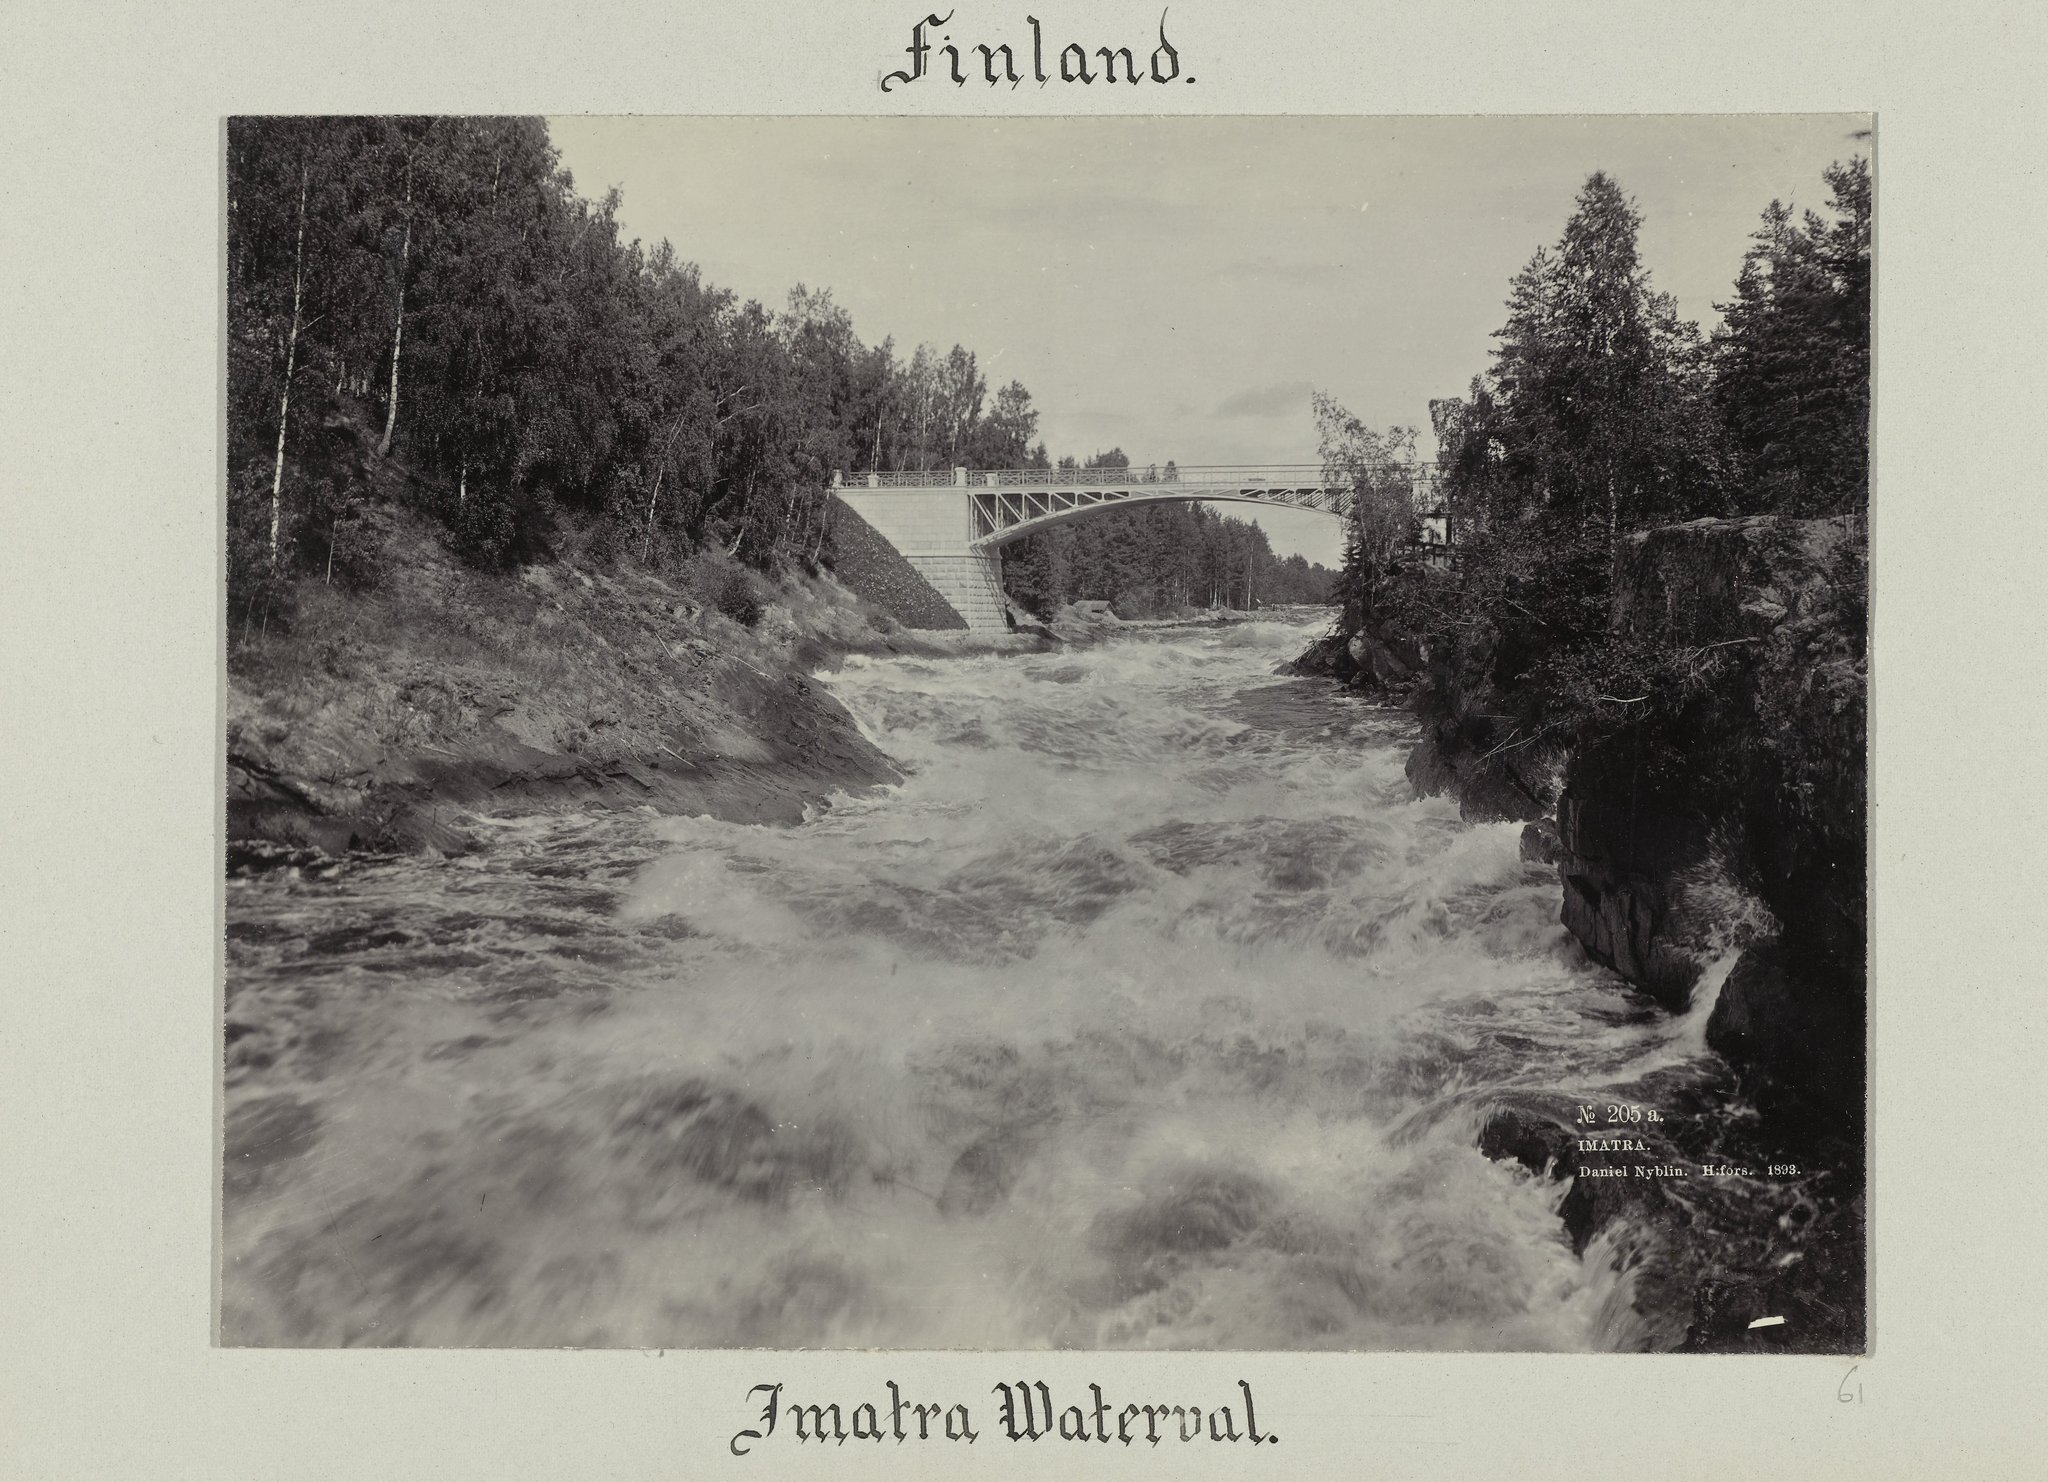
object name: photograph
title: No 205a Imatra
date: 1893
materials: paper, photographic support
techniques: albumen print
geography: netherlands